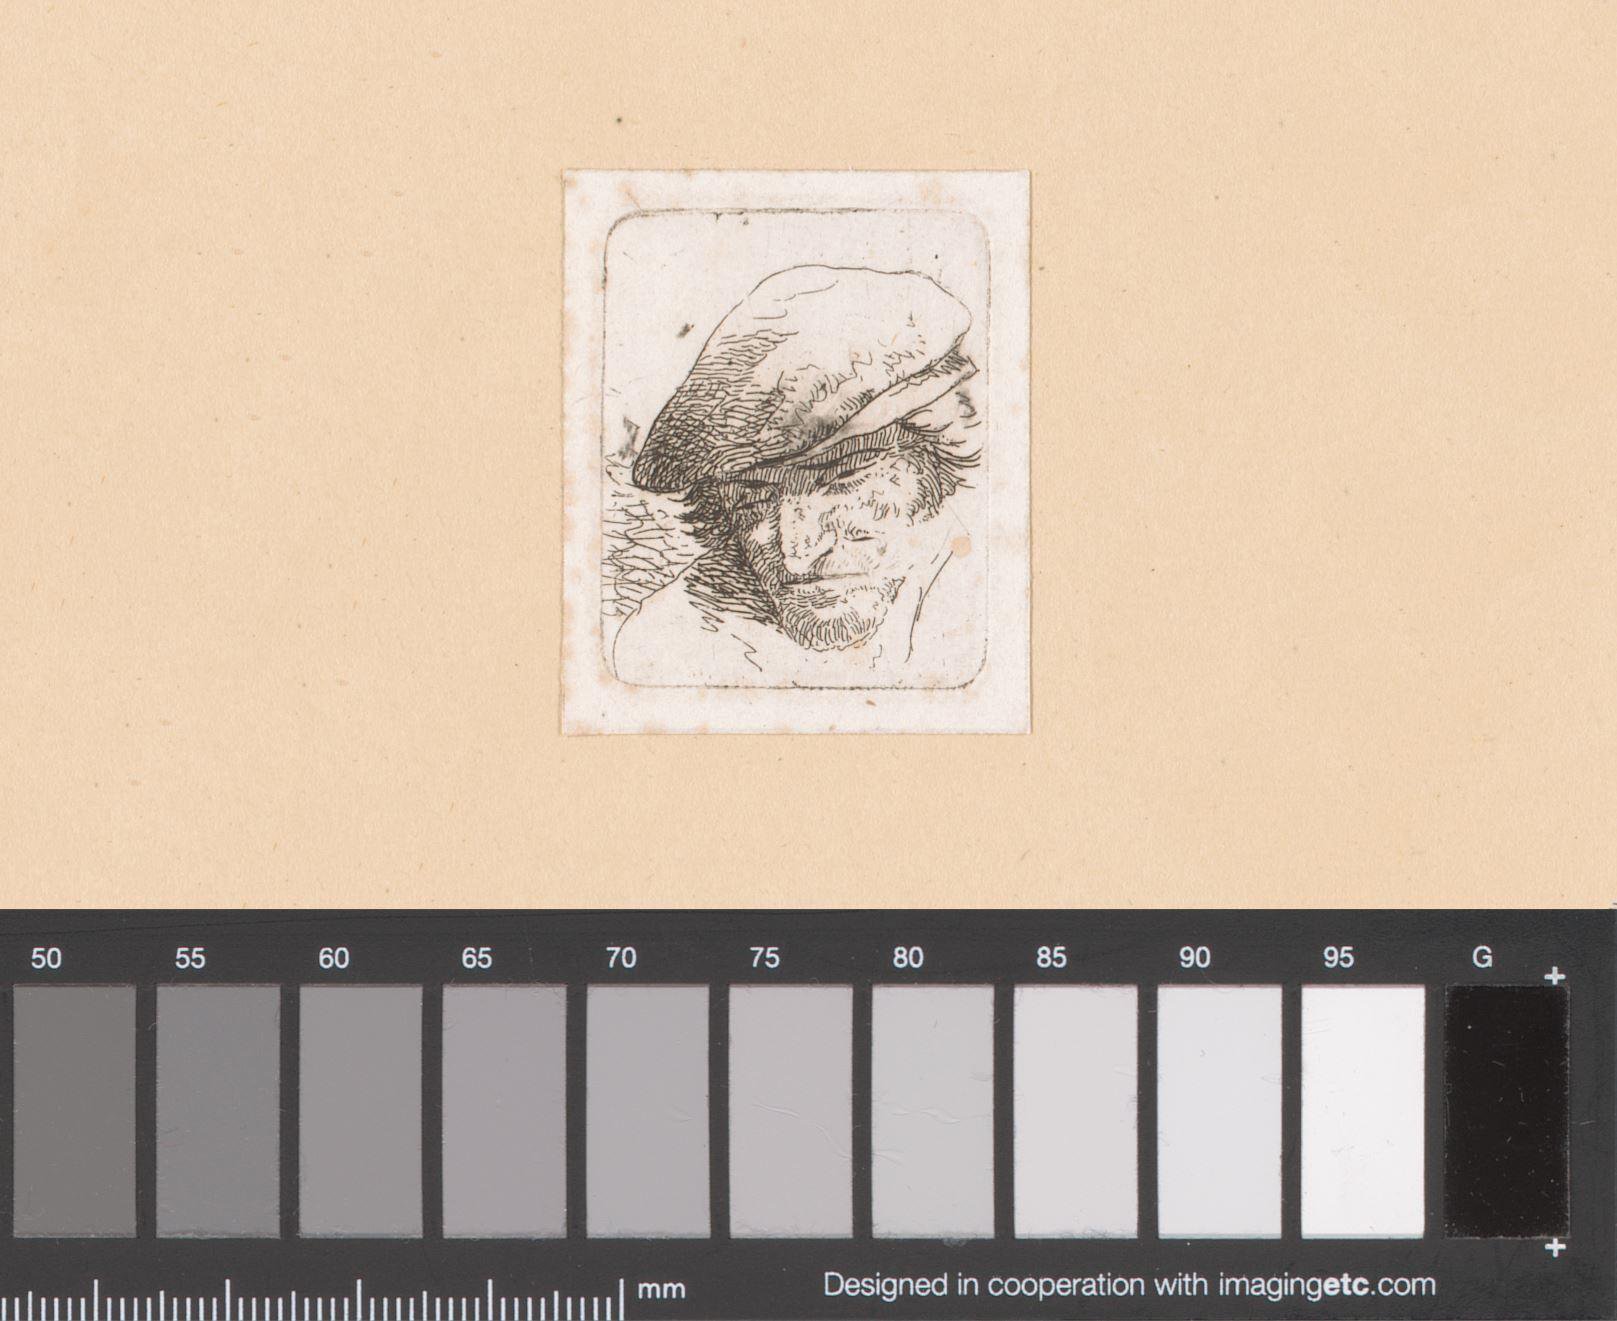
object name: print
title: Kop van een onbekende man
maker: johann friedrich morgenstern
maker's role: print maker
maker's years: 1777-1844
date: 1787-1844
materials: paper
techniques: etching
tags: adult man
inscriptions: collector's mark: Lugt 2228